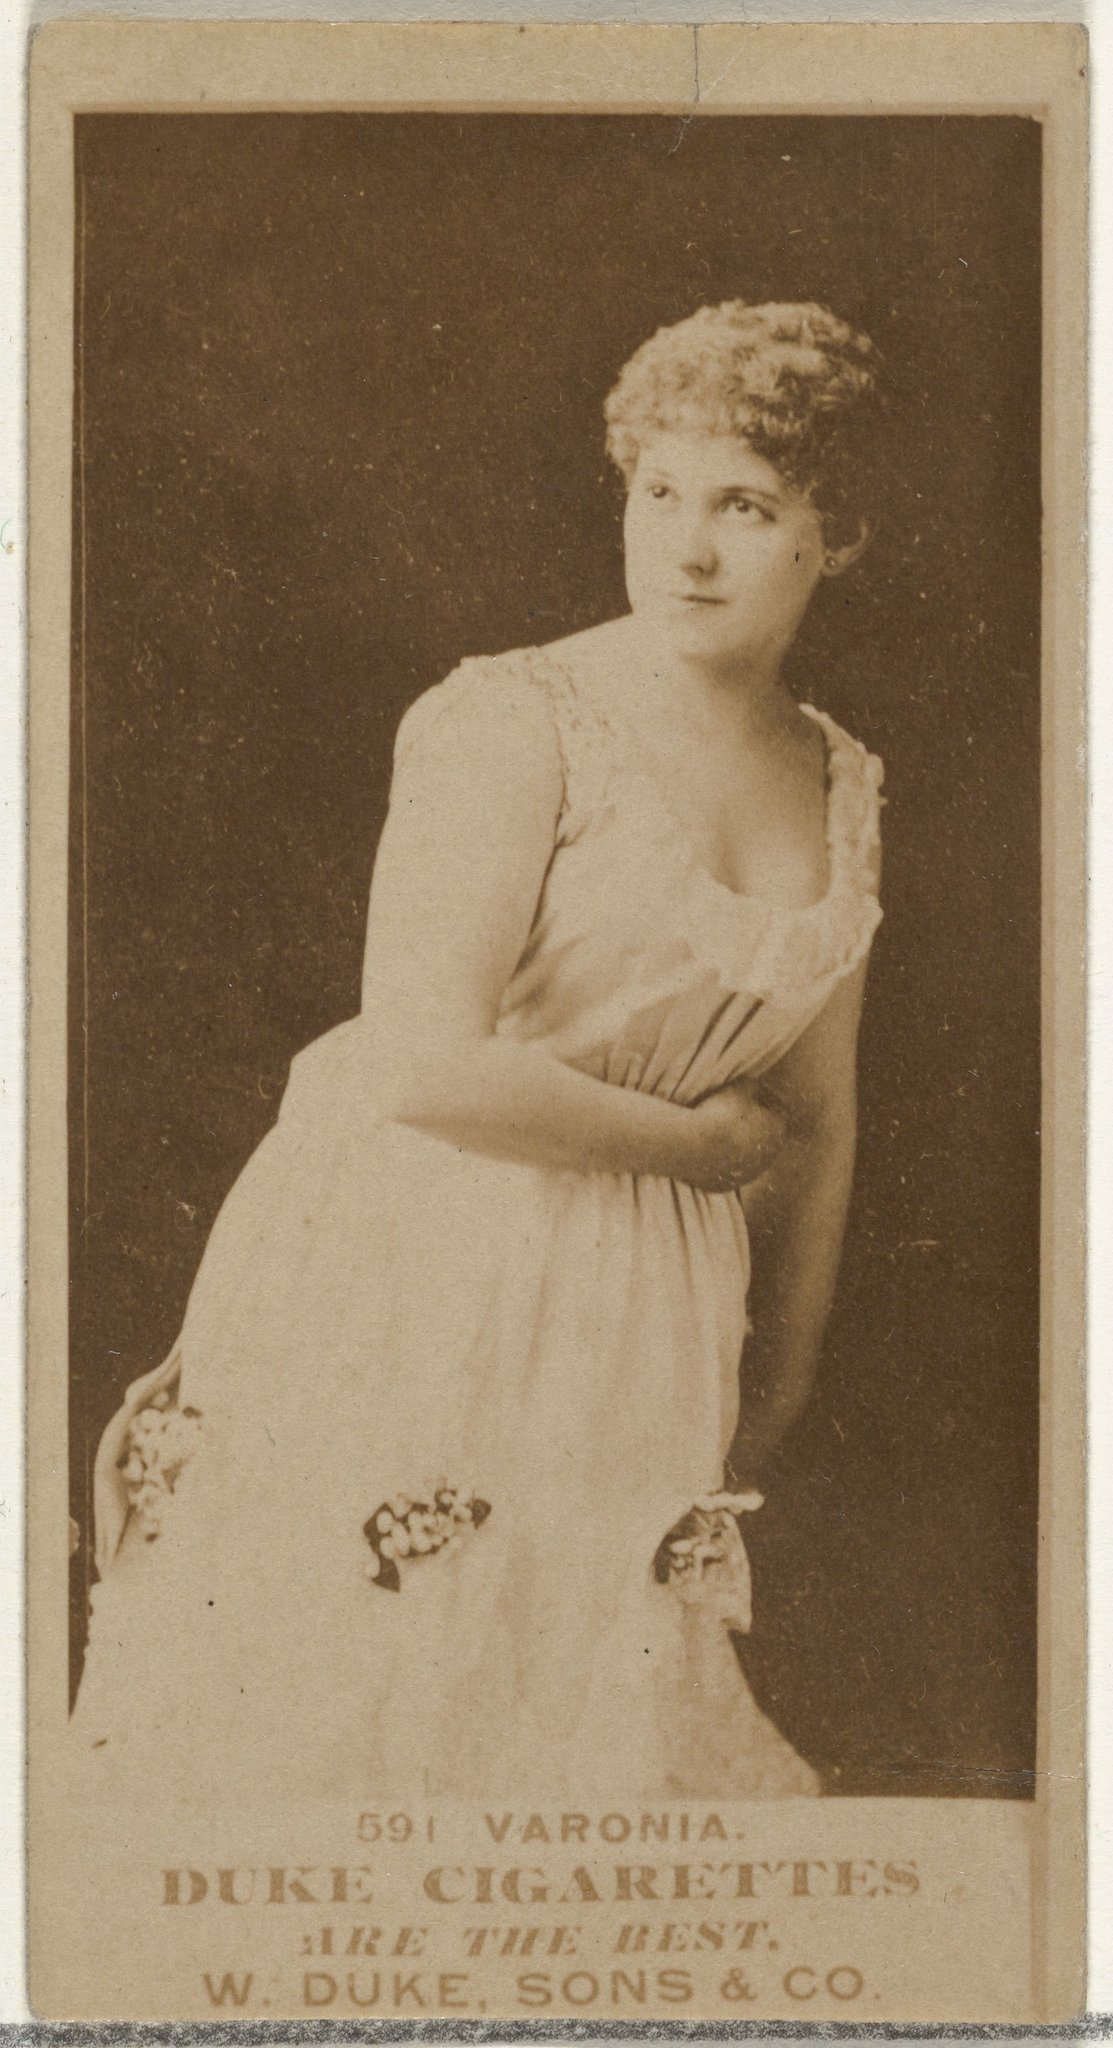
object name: photograph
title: Card Number 591, Varonia, from the Actors and Actresses series (N145-7) issued by Duke Sons & Co. to promote Duke Cigarettes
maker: w. duke, sons & co.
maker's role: publisher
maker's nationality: american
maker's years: 1870-1920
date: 1880-1889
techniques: albumen silver print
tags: portraits,women,actresses